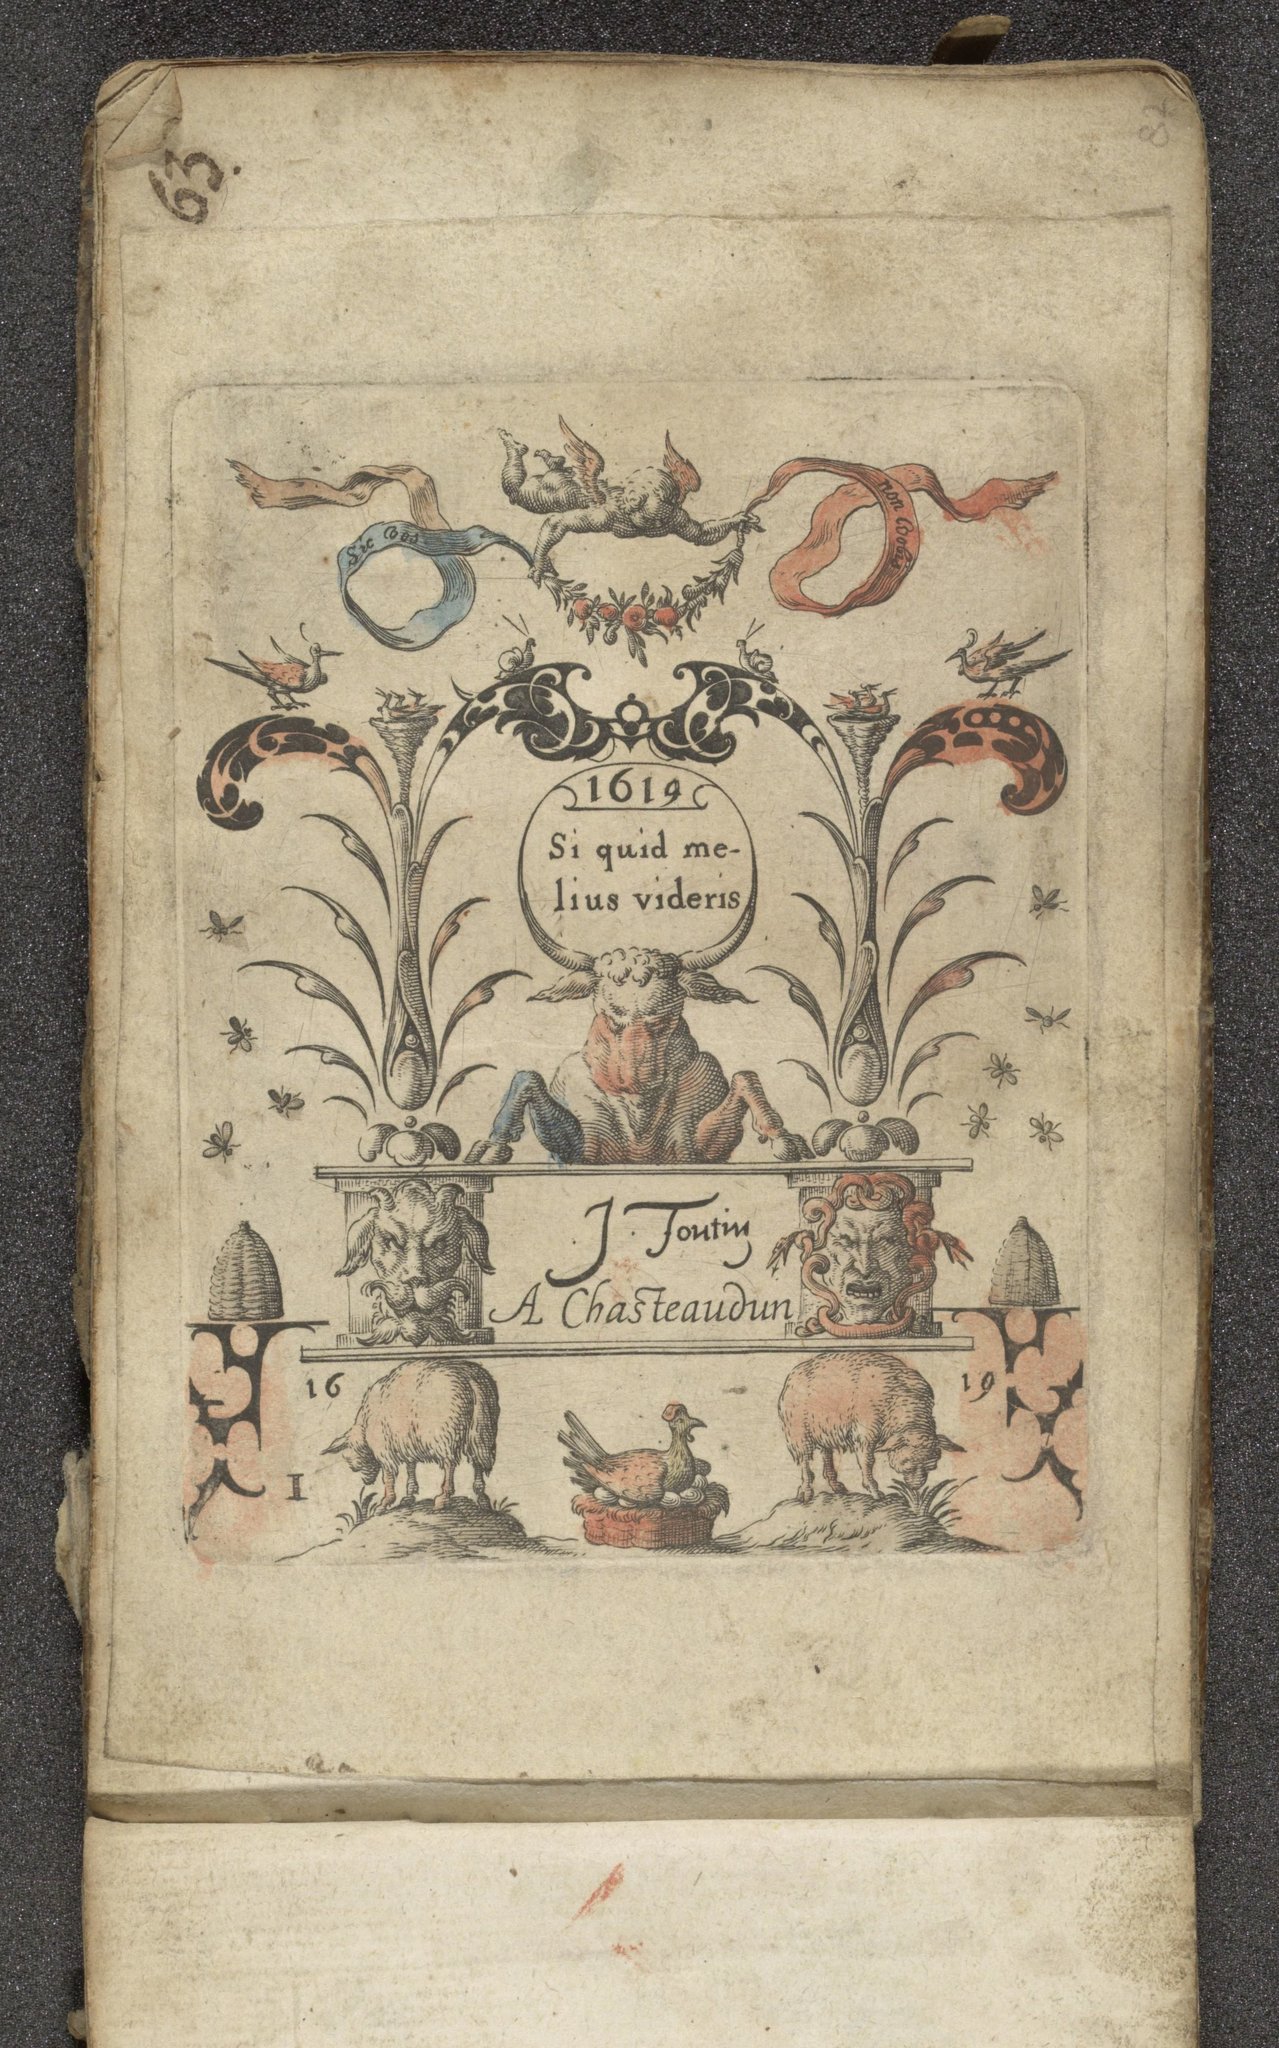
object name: titelprent, frontispice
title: Stier met voorpoten op een verhoging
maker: jean toutin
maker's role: print maker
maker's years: 1578-1644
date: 1619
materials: paper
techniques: colour, engraving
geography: châteaudun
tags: ornaments ~ art, title-page, sheep, bee-hive, ox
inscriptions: inscription: ‘63’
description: Een stier of os met de titel van de serie tussen zijn horens en zijn voorpoten op een verhoging met twee pilaren en mascarons. Aan beide zijden een bijenkorf en op de voorgrond twee grazende schapen en een kip in een mand met eieren. Bovenaan een putto met een guirlande en een lint met het devies: Sic vos non vobis. Linksonder genummerd I. De prent maakt deel uit van een album.